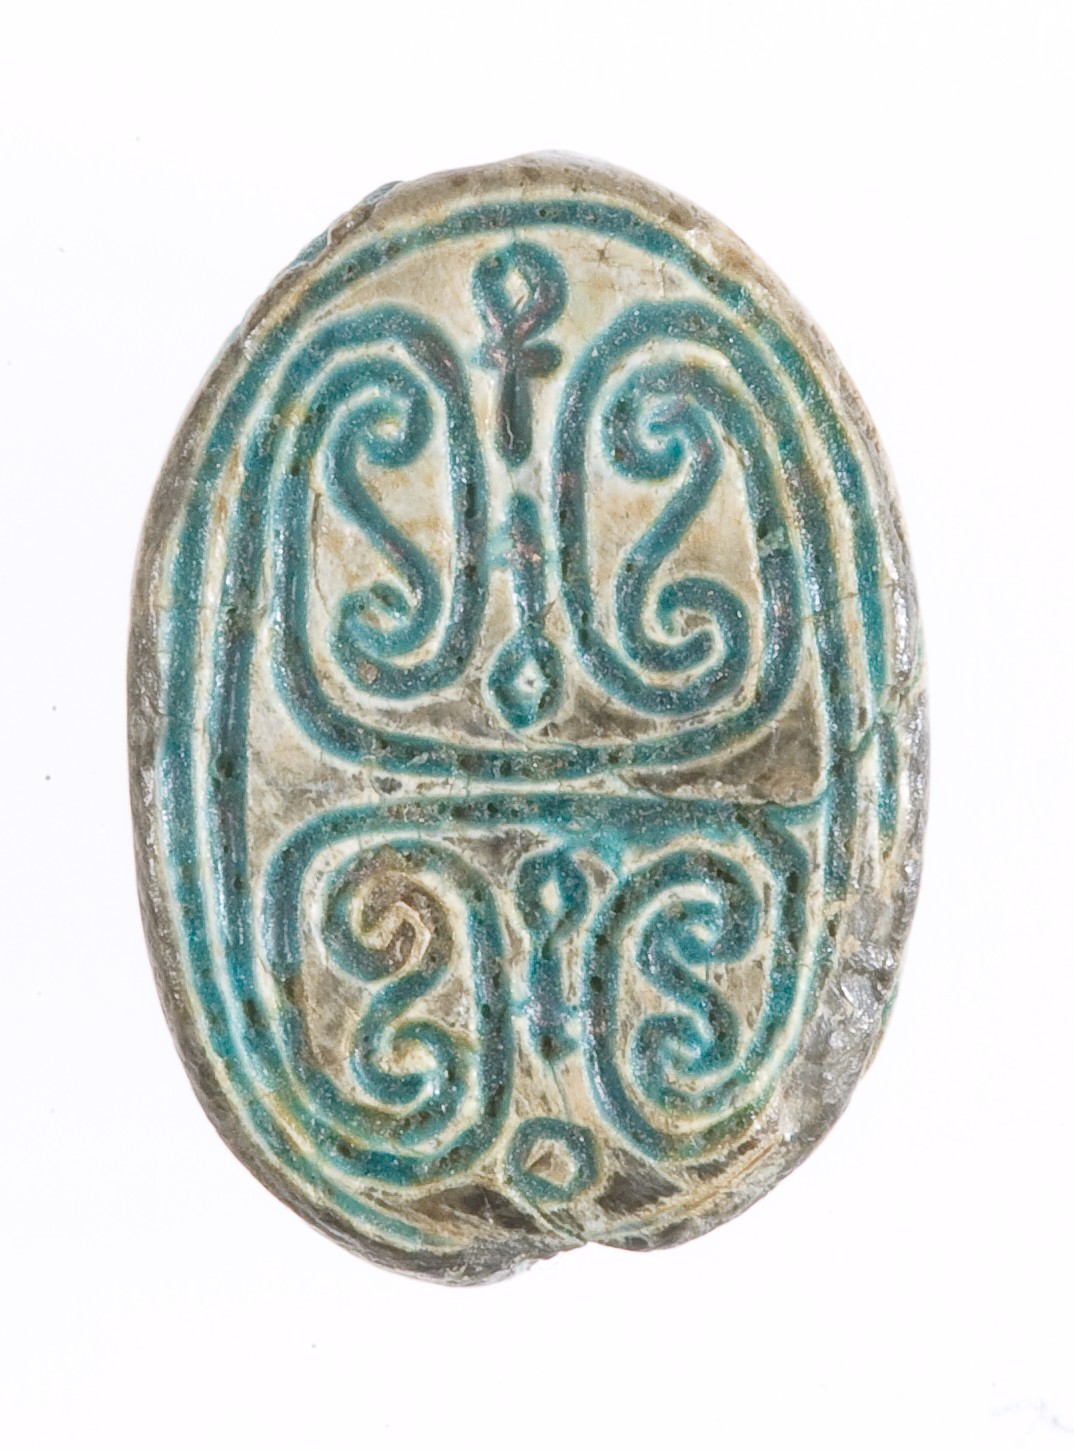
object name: scarab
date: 1635-1458 BCE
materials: stone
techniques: glazing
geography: egypt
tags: scarabs